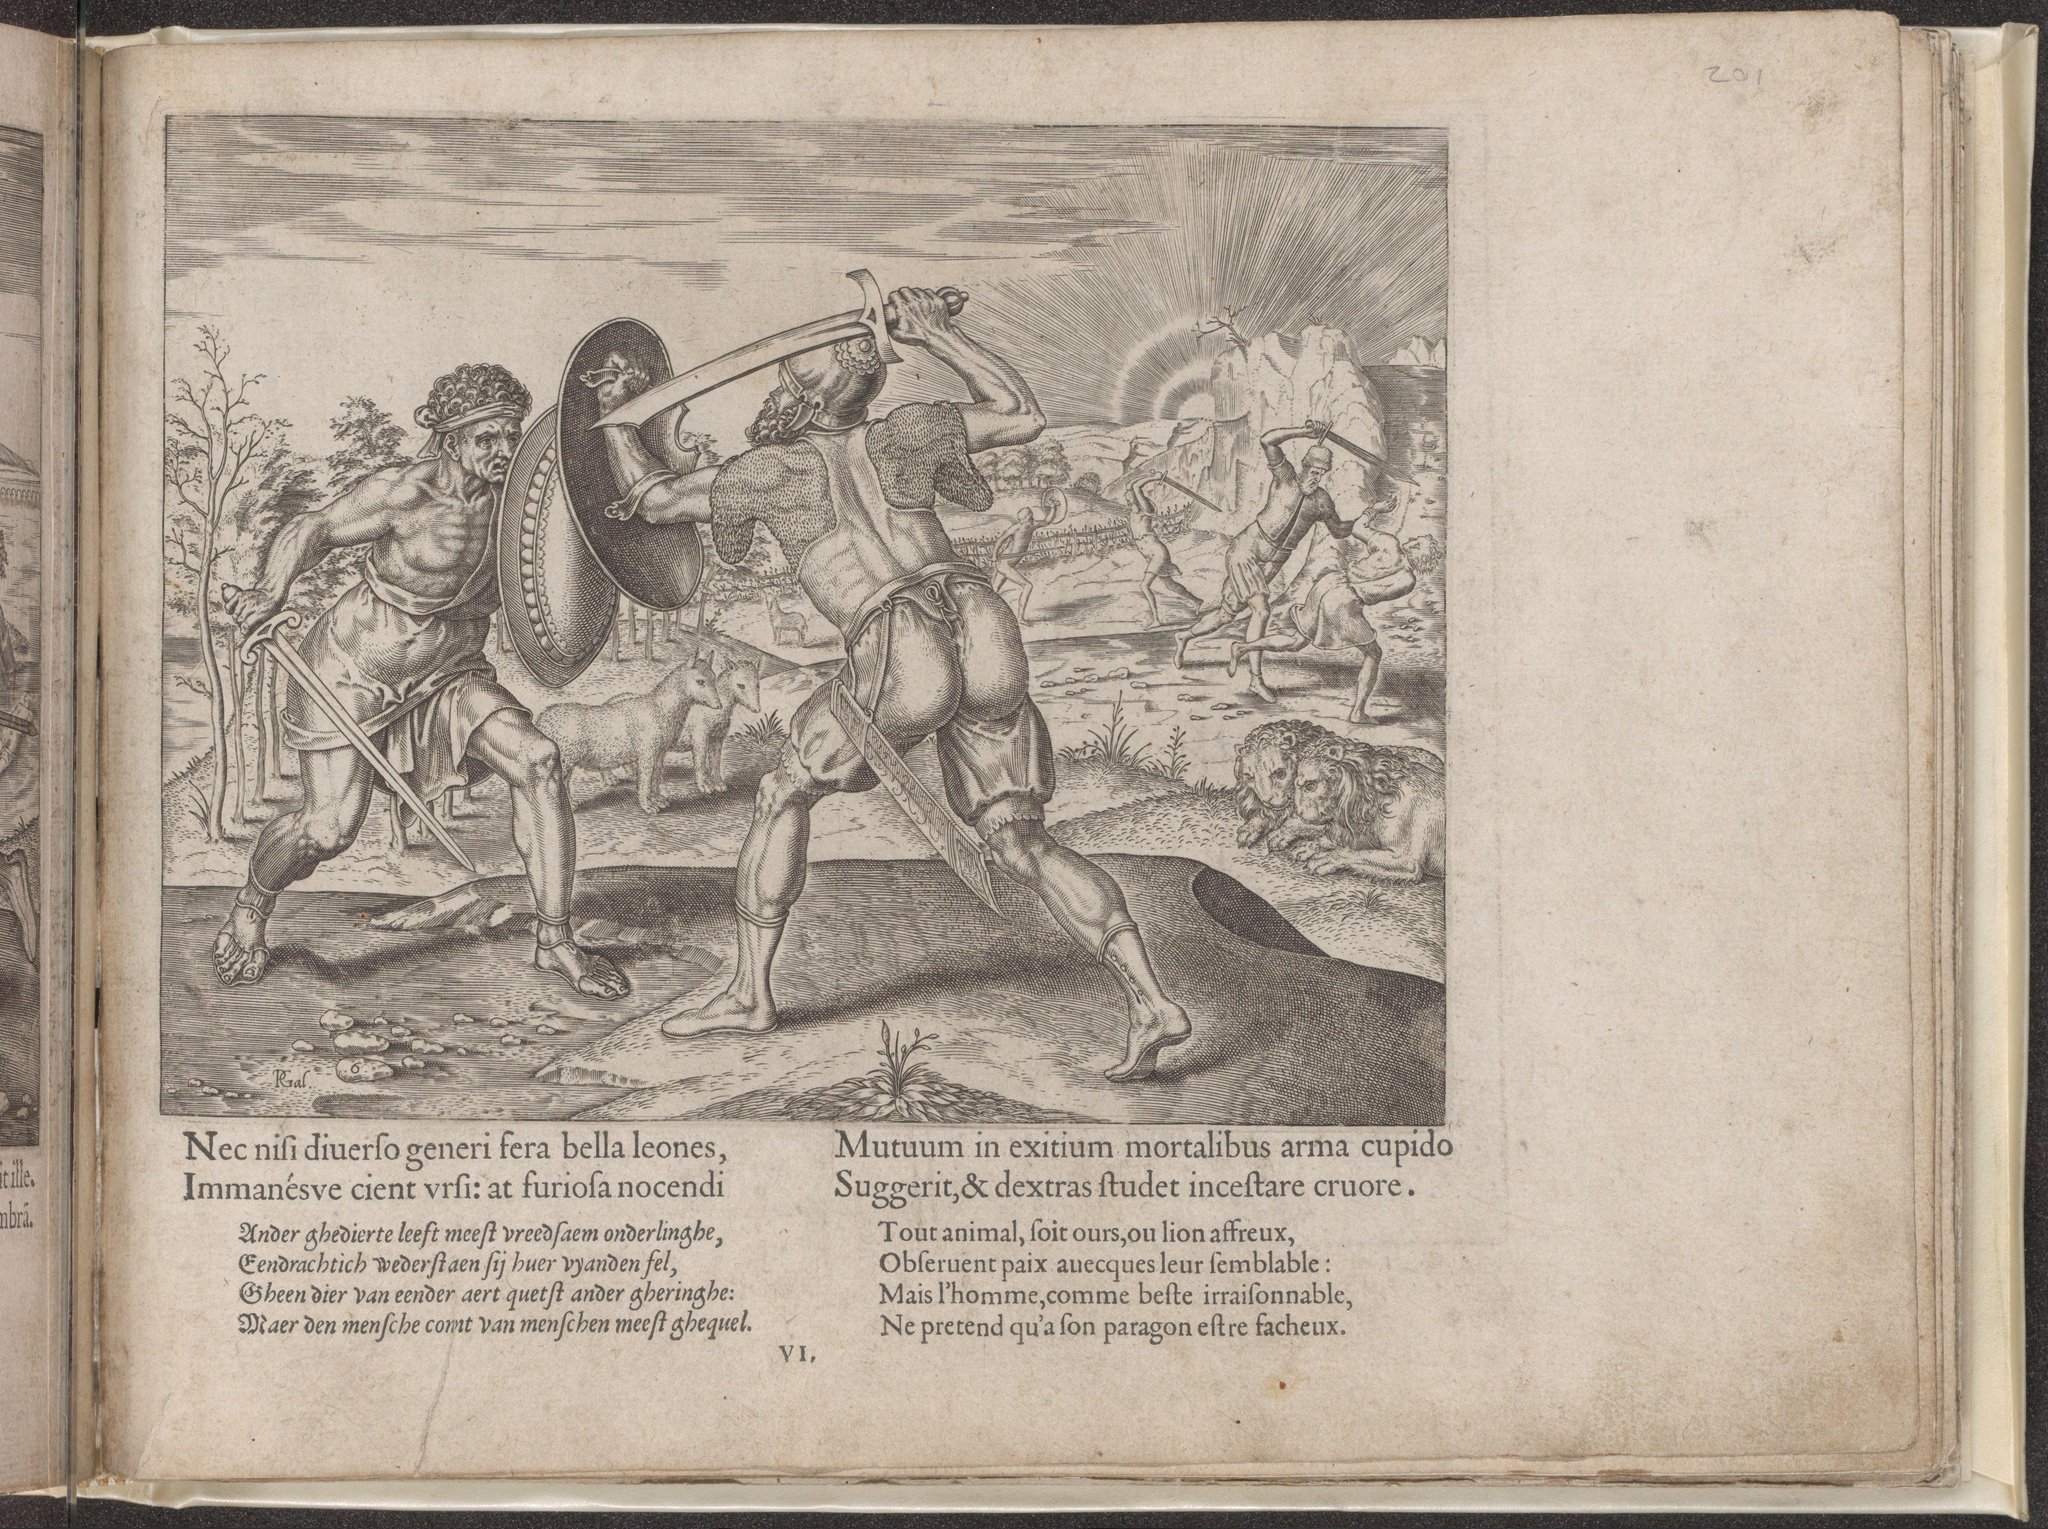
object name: album leaf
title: Ellende van het menselijk bestaan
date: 1563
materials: paper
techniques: engraving, letterpress printing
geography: haarlem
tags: beasts of prey, predatory animals: bear, violent death, being killed; being mishandled and maltreated; seeking death, beasts of prey, predatory animals: lion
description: In de voorgrond vechten twee mannen tegen elkaar. In de achtergrond zijn ook mannen aan het vechten. Twee leeuwen en twee beren zitten vreedzaam naast elkaar. Dieren vechten nooit tegen hun soortgenoten, maar de mens grijpt snel naar de wapens om zijn eigen soortgenoten ten gronde te richten. Onder de voorstelling een vers in het Latijn en een Nederlands en Frans onderschrift in boekdruk. Deze prent maakt deel uit van een album.